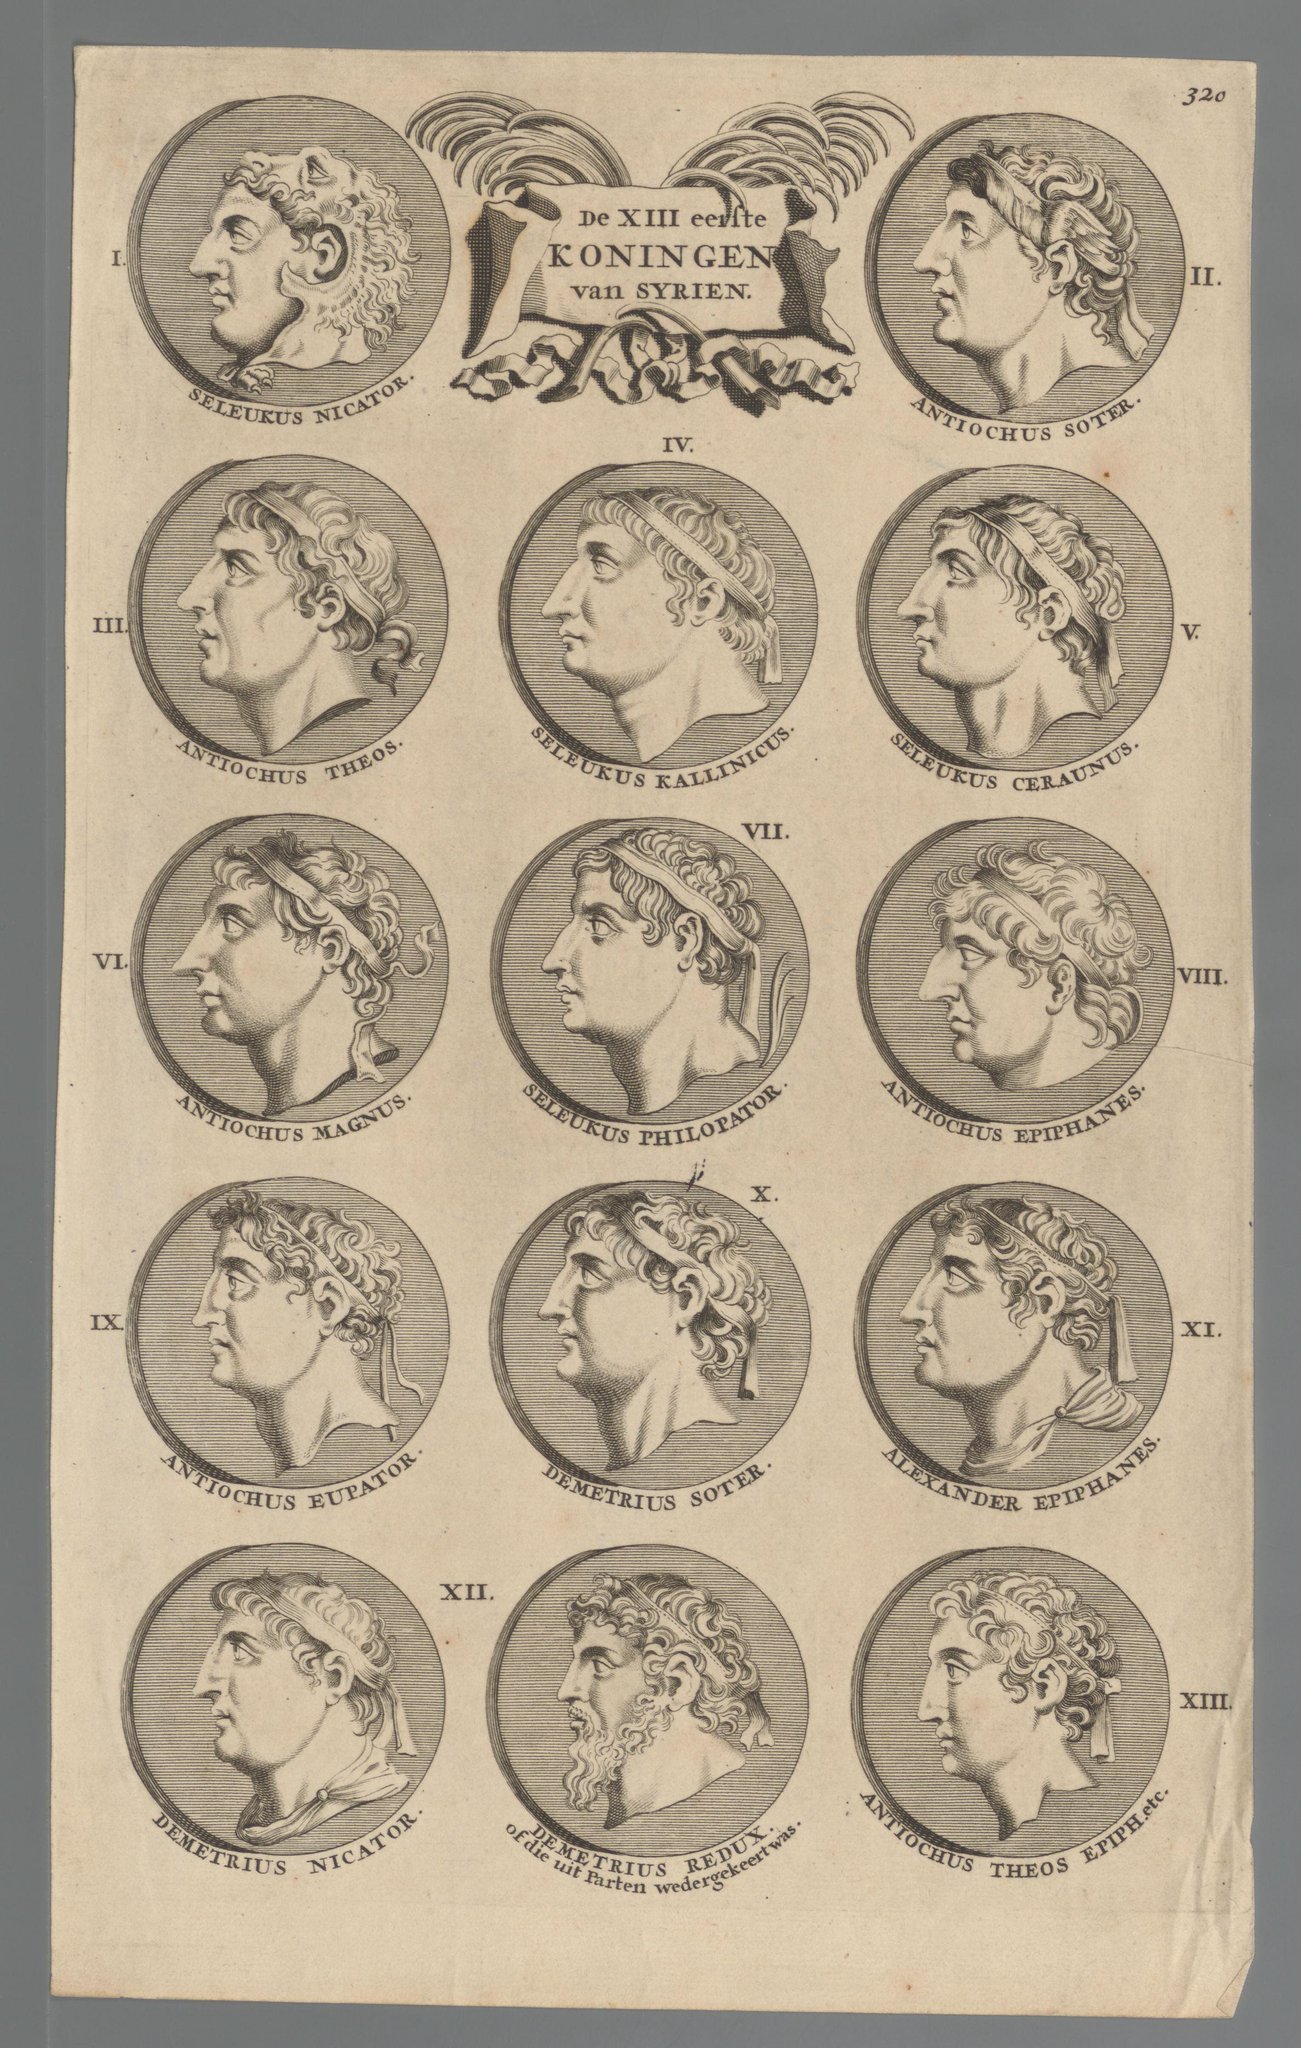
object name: print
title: Medailles met veertien portretten van Syrische koningen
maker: Anonymous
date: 1700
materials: paper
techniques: engraving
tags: historical persons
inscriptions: collector's mark: Lugt 2228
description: Rechtsboven genummerd: 327. Portretten van Tryphon, Sidetes, Alexander II Zabinas, Antiochus VIII Grypos, Antiochus IX Cyzicenus, Seleucus VI Epiphanes, Antiochus XI Epiphanes, Antiochus X Eusebes, Philip I Philadelphus, Antiochus XIII Asiaticus, Tigranes II en Artavasdes II.